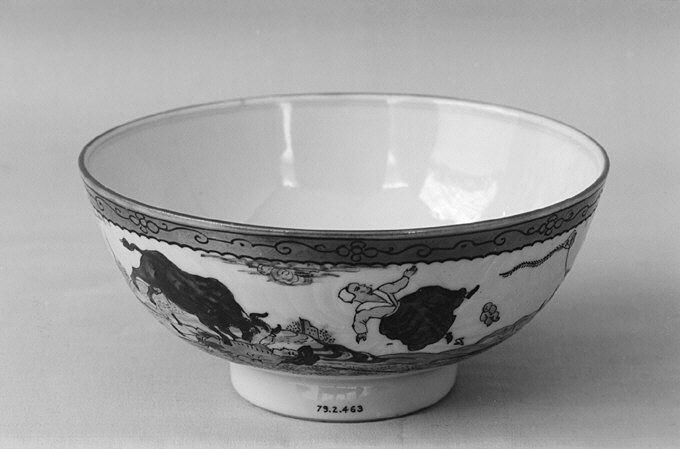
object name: bowl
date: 1701-1800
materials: hard paste porcelain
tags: human figures,bulls